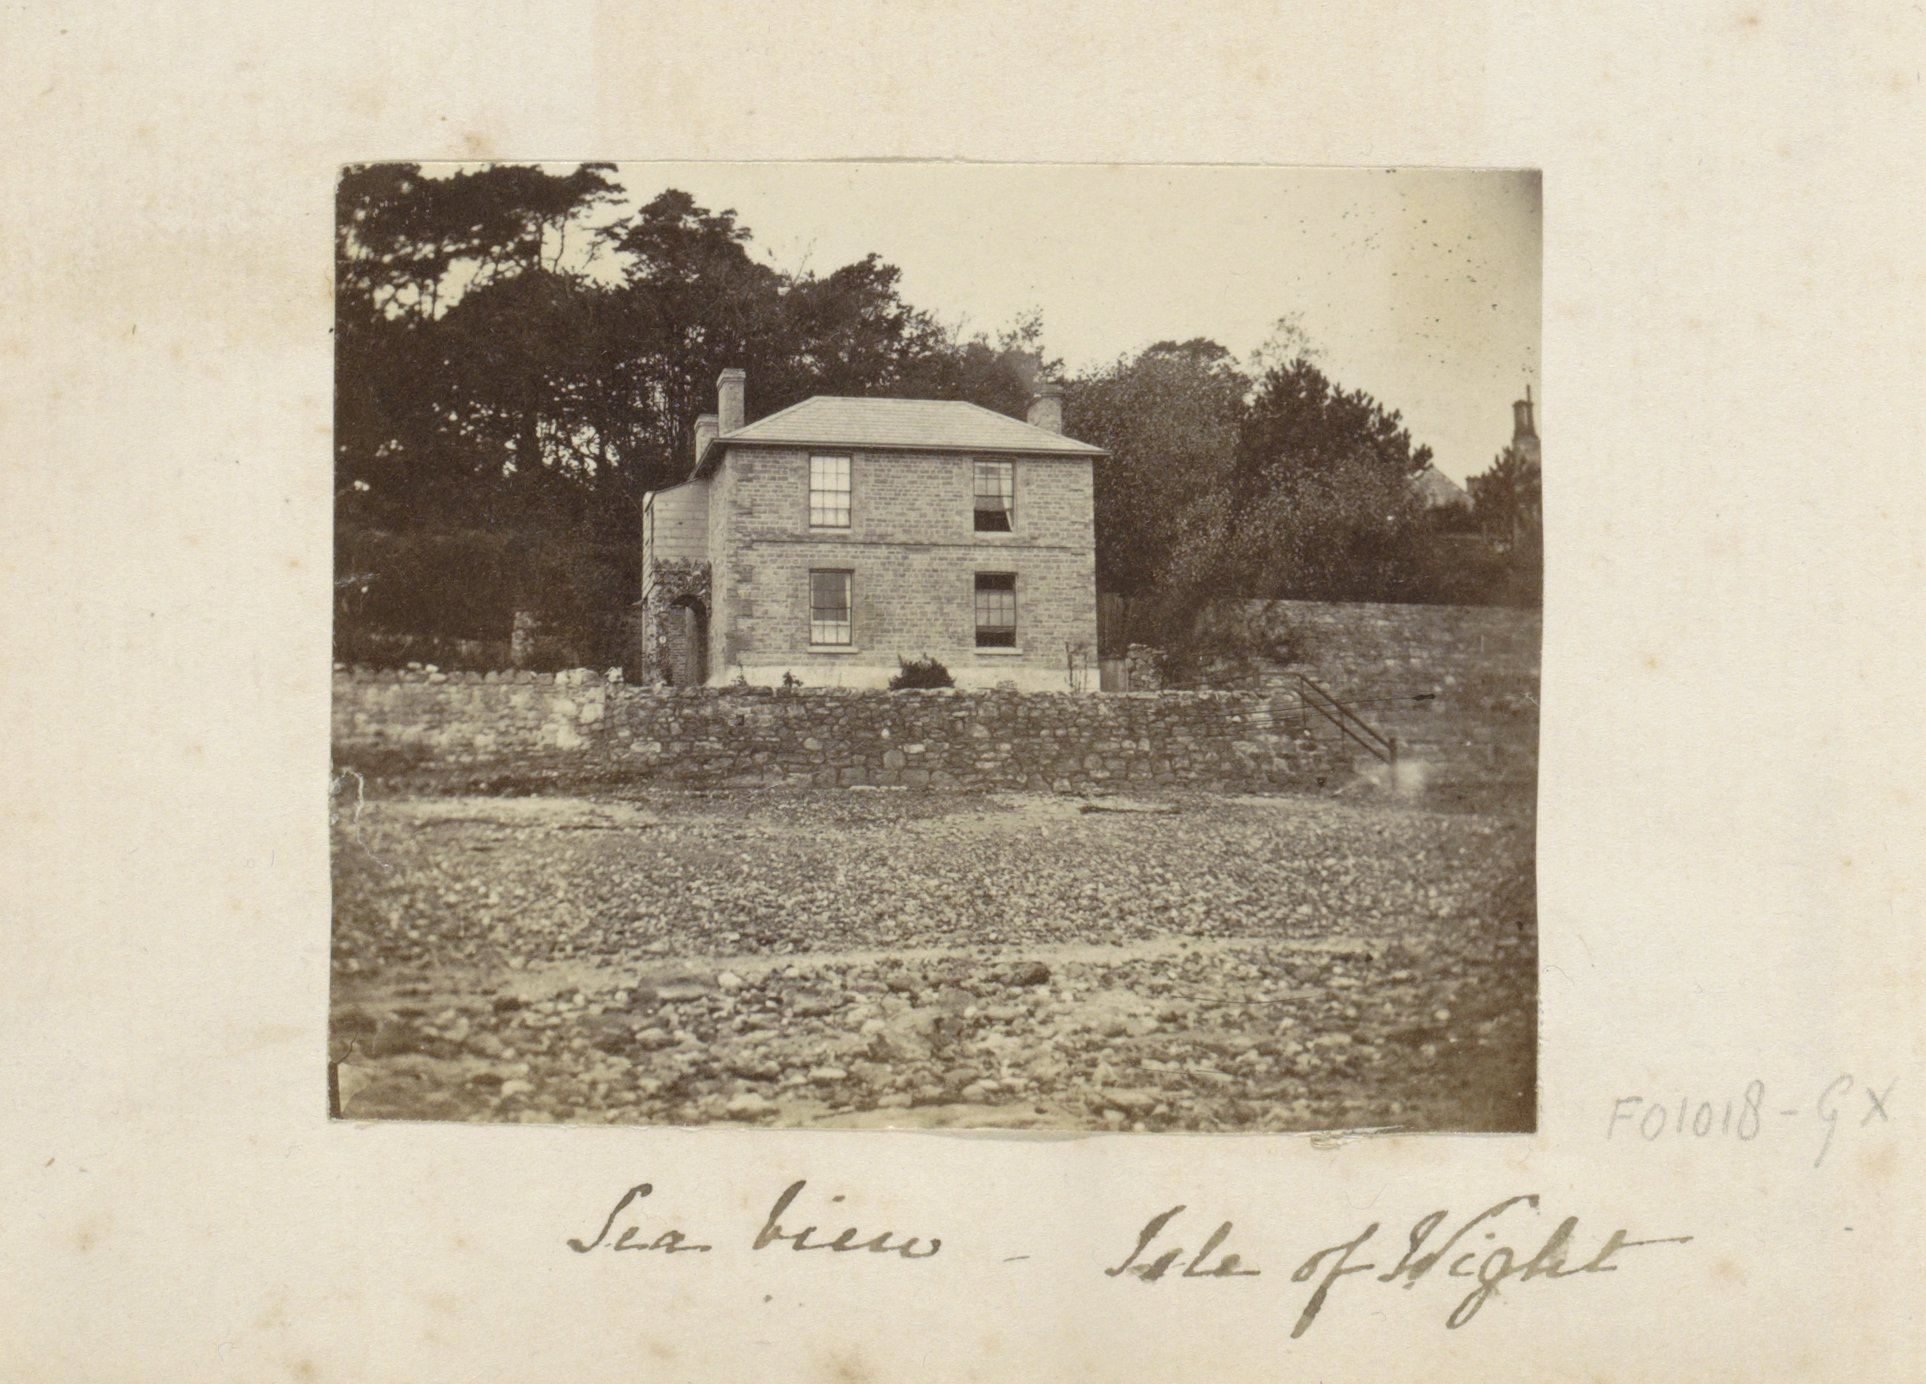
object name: photograph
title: Sea View - Isle of Wight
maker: Anonymous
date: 1860-1870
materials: paper, photographic support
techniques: albumen print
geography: seaview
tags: fence, wall, paling, rural housing, e.g. country-house, villa, cottage, front steps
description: Onderdeel van Engels familiealbum met foto's van personen, reizen, cricket en kunstwerken.